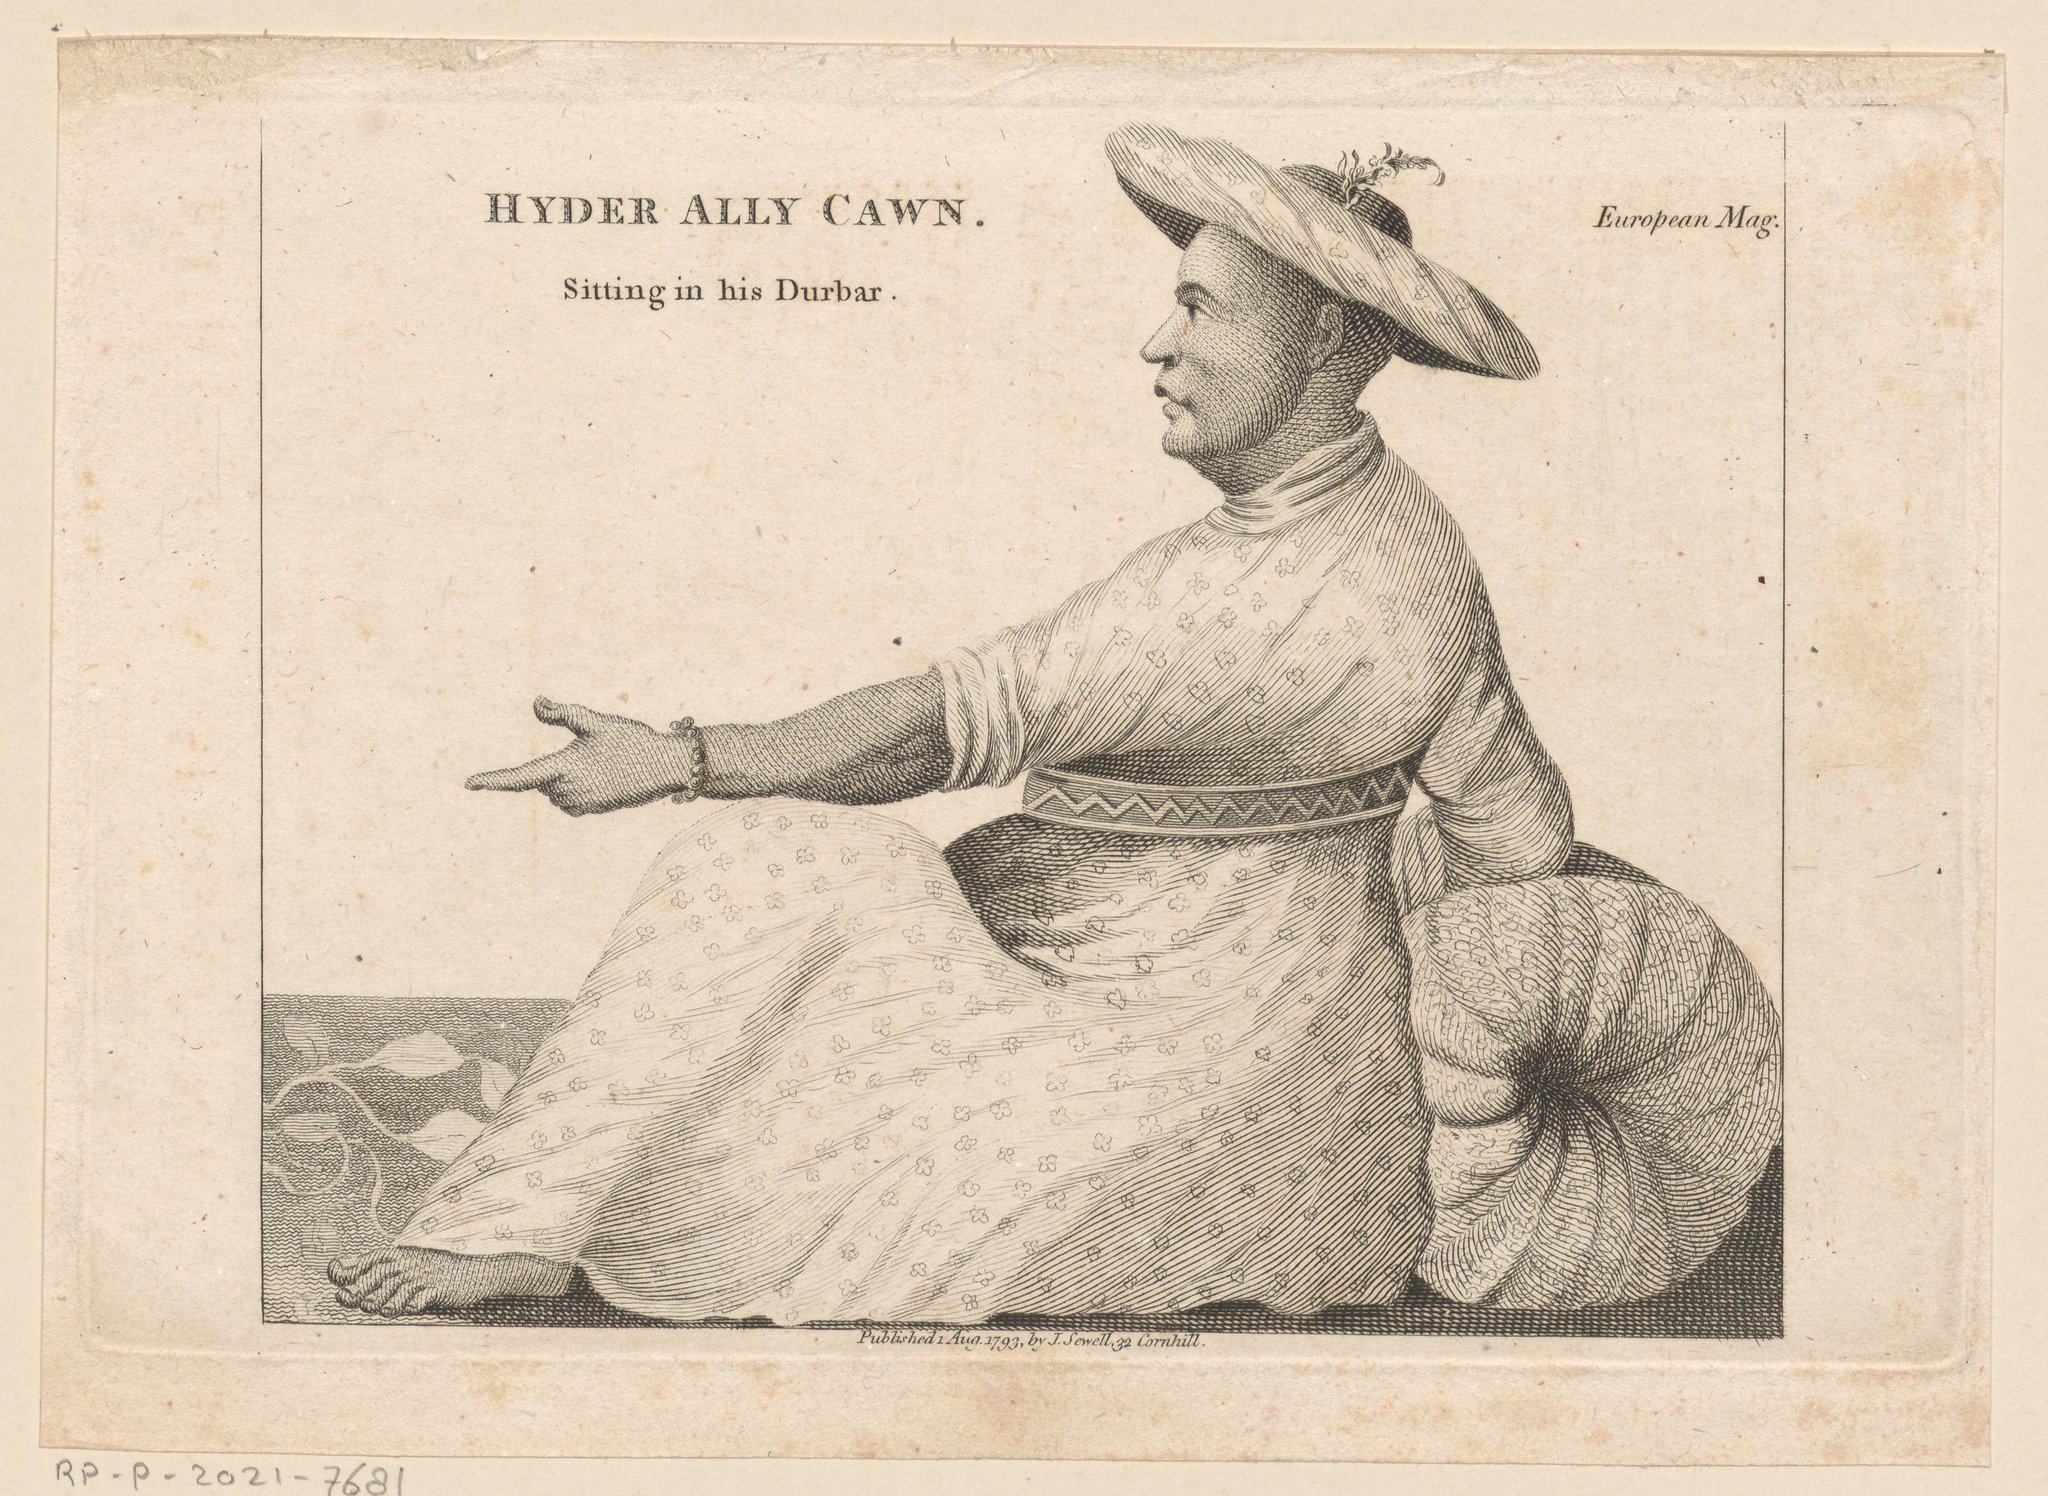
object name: print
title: Portret van Haidar Ali, sultan van Mysore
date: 1793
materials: paper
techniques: engraving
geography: london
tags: historical persons, ruler, sovereign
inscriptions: date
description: Prent uit: The European Magazine, 1 augustus 1793.